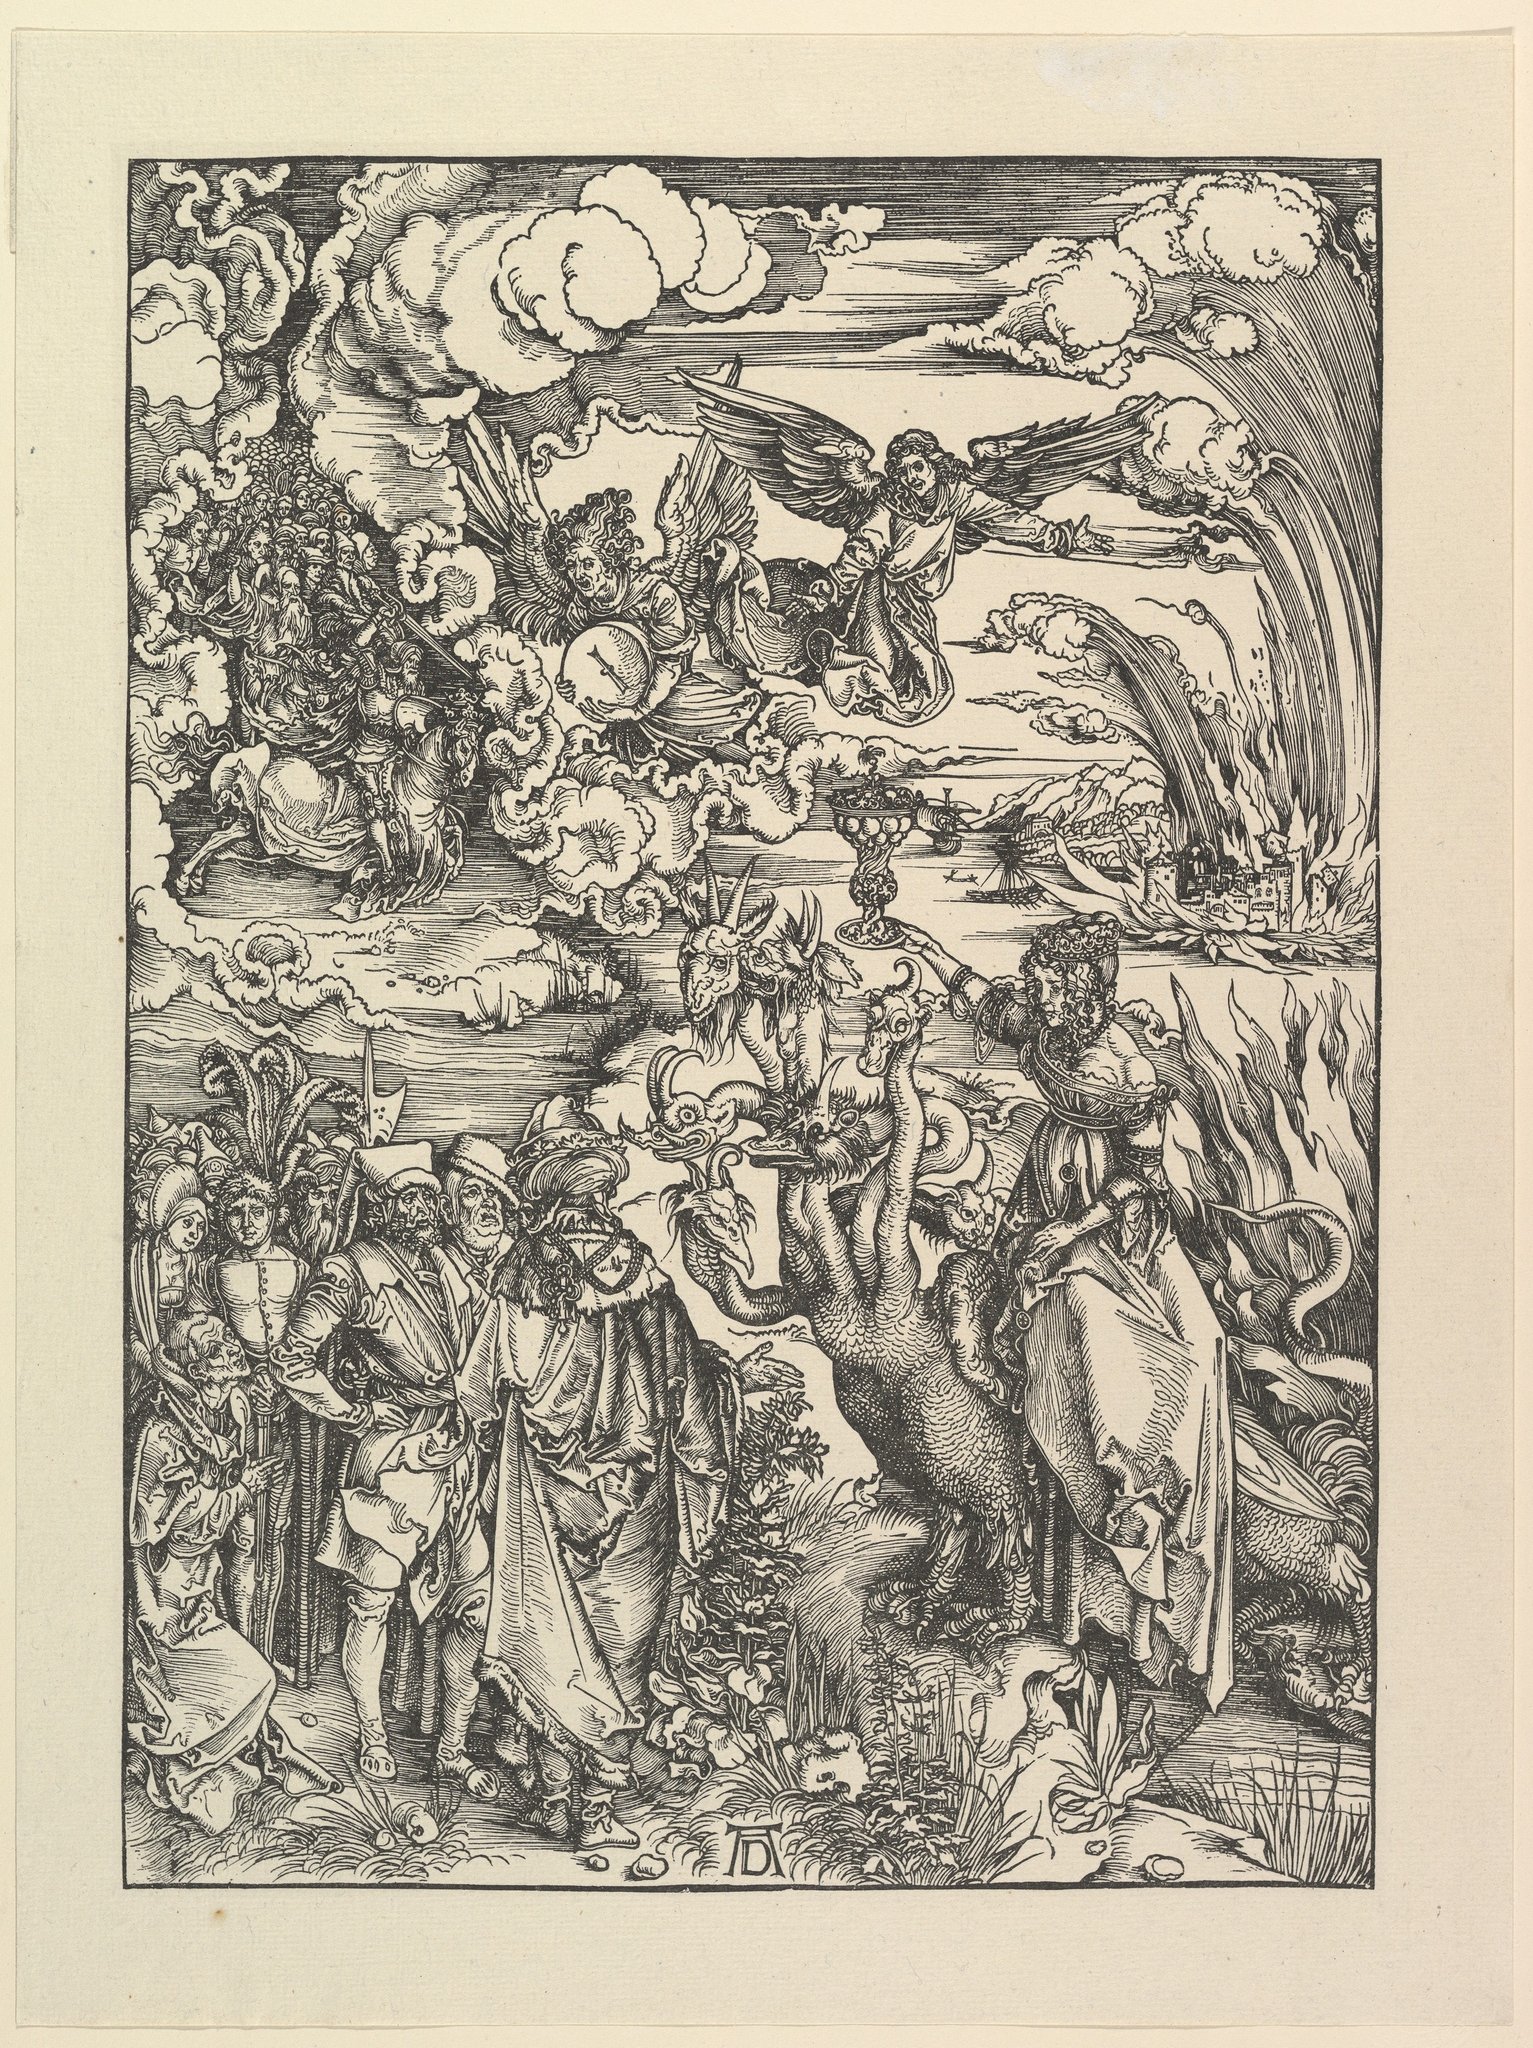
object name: print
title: The Babylonian Whore, from The Apocalypse. Facsimile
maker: albrecht dürer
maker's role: artist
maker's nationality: german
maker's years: 1471-1528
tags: men,women